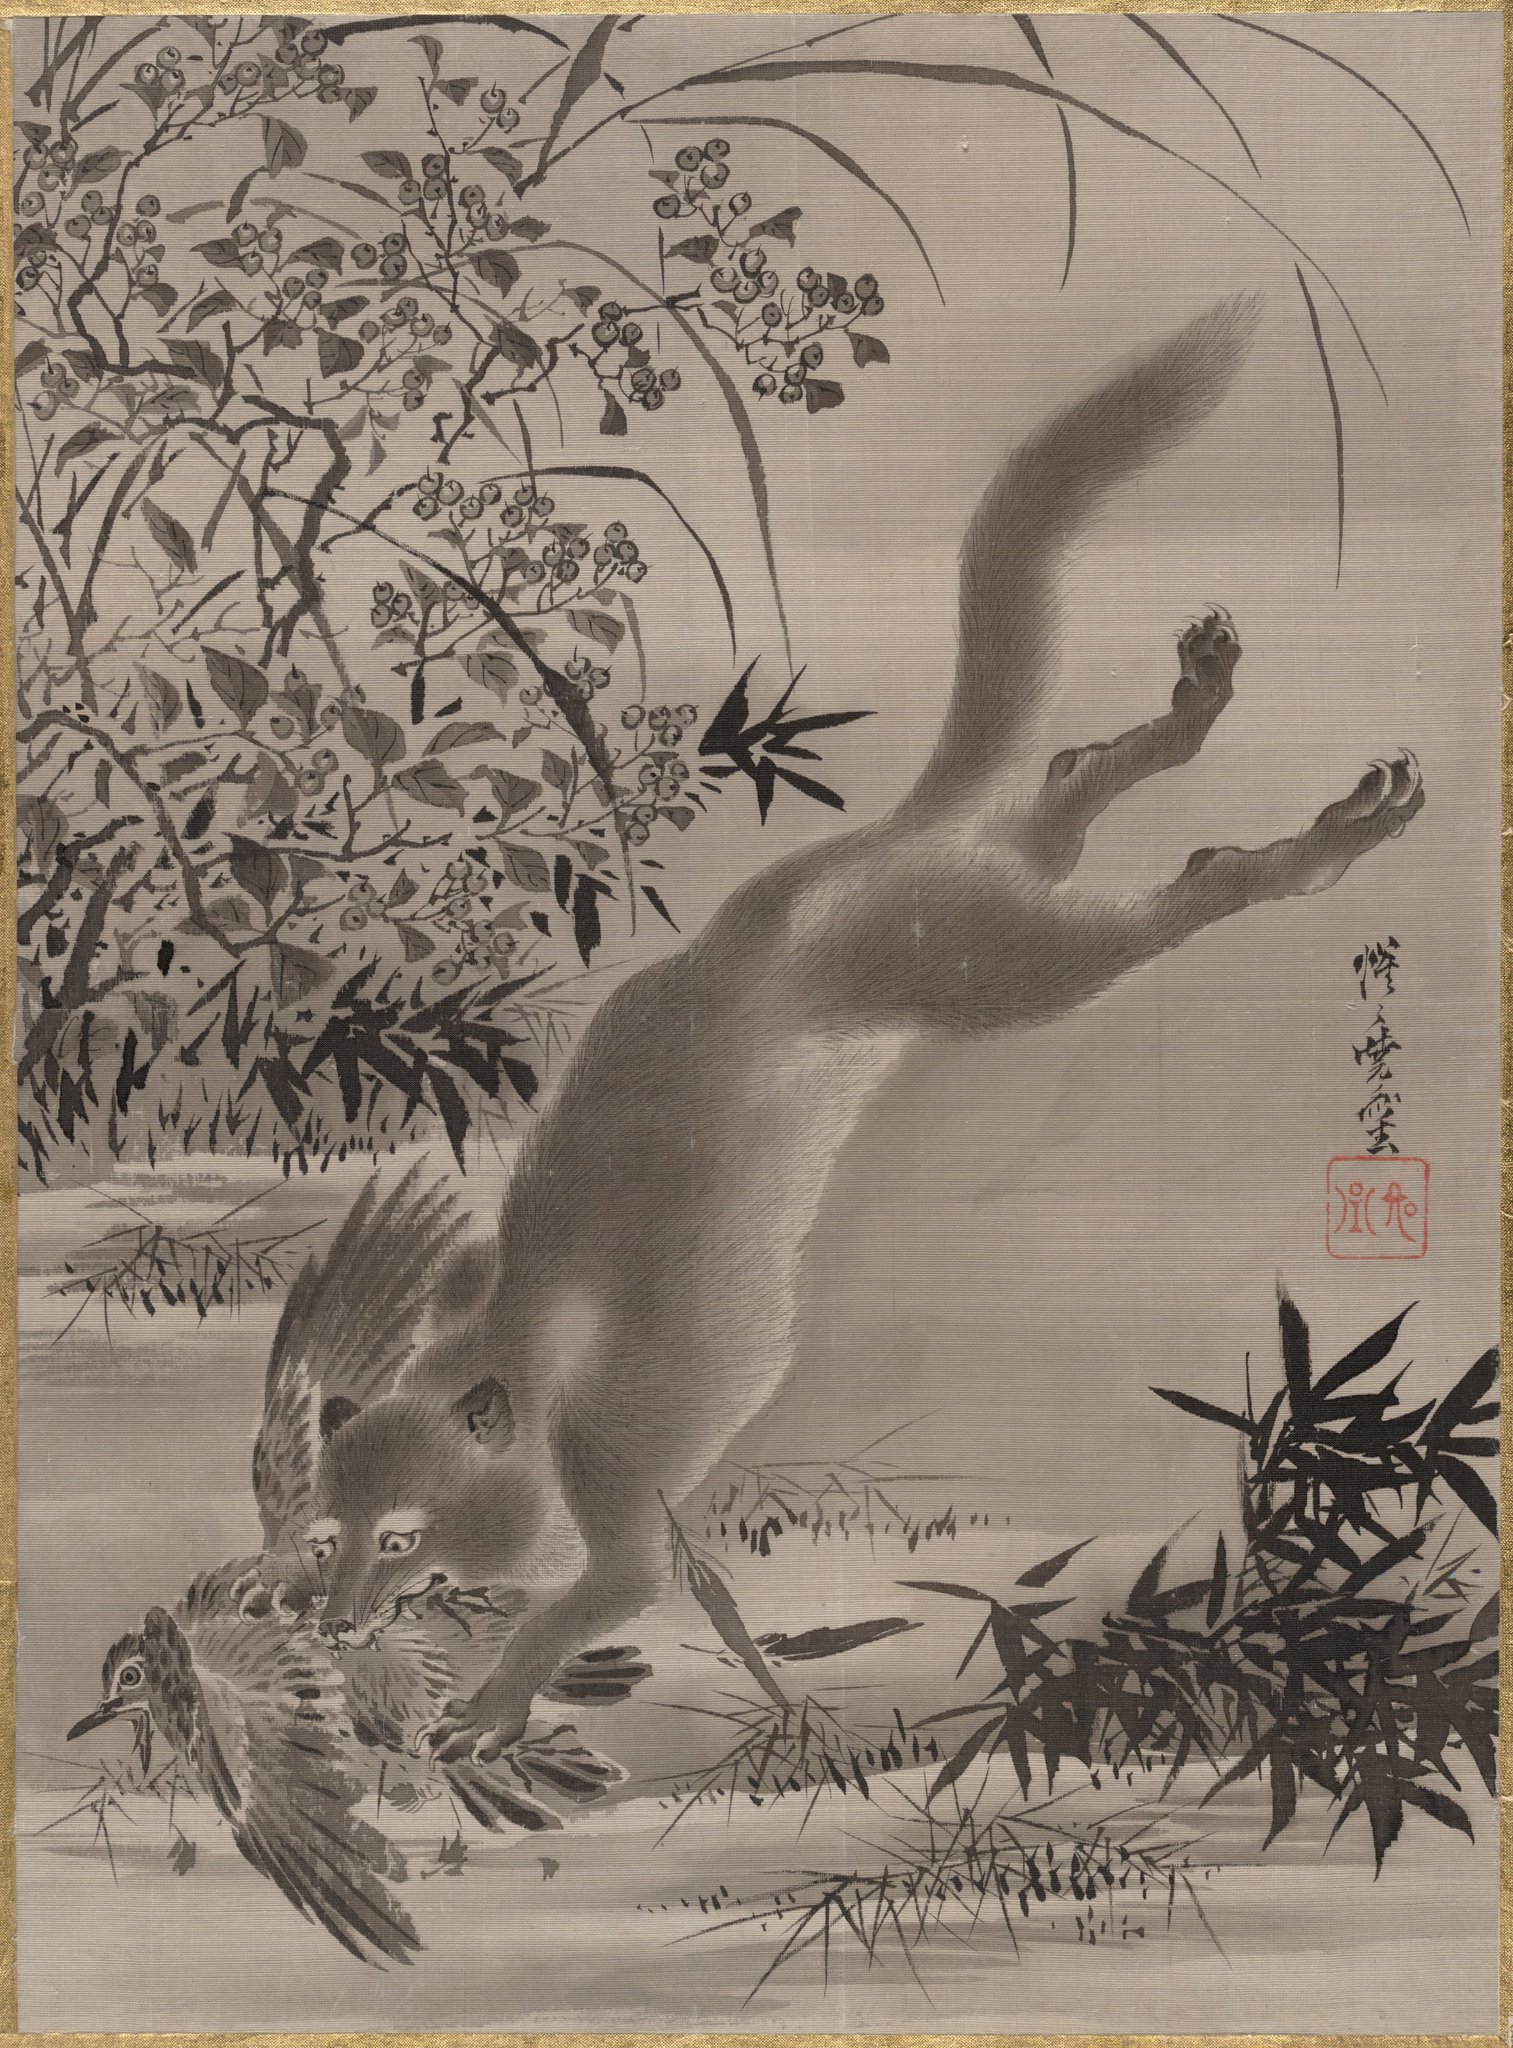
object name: album leaf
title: Fox Catching Bird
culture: japanese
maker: kawanabe kyōsai 河鍋暁斎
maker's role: artist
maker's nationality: japanese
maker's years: 1831-1889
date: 1887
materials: ink, silk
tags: birds,foxes